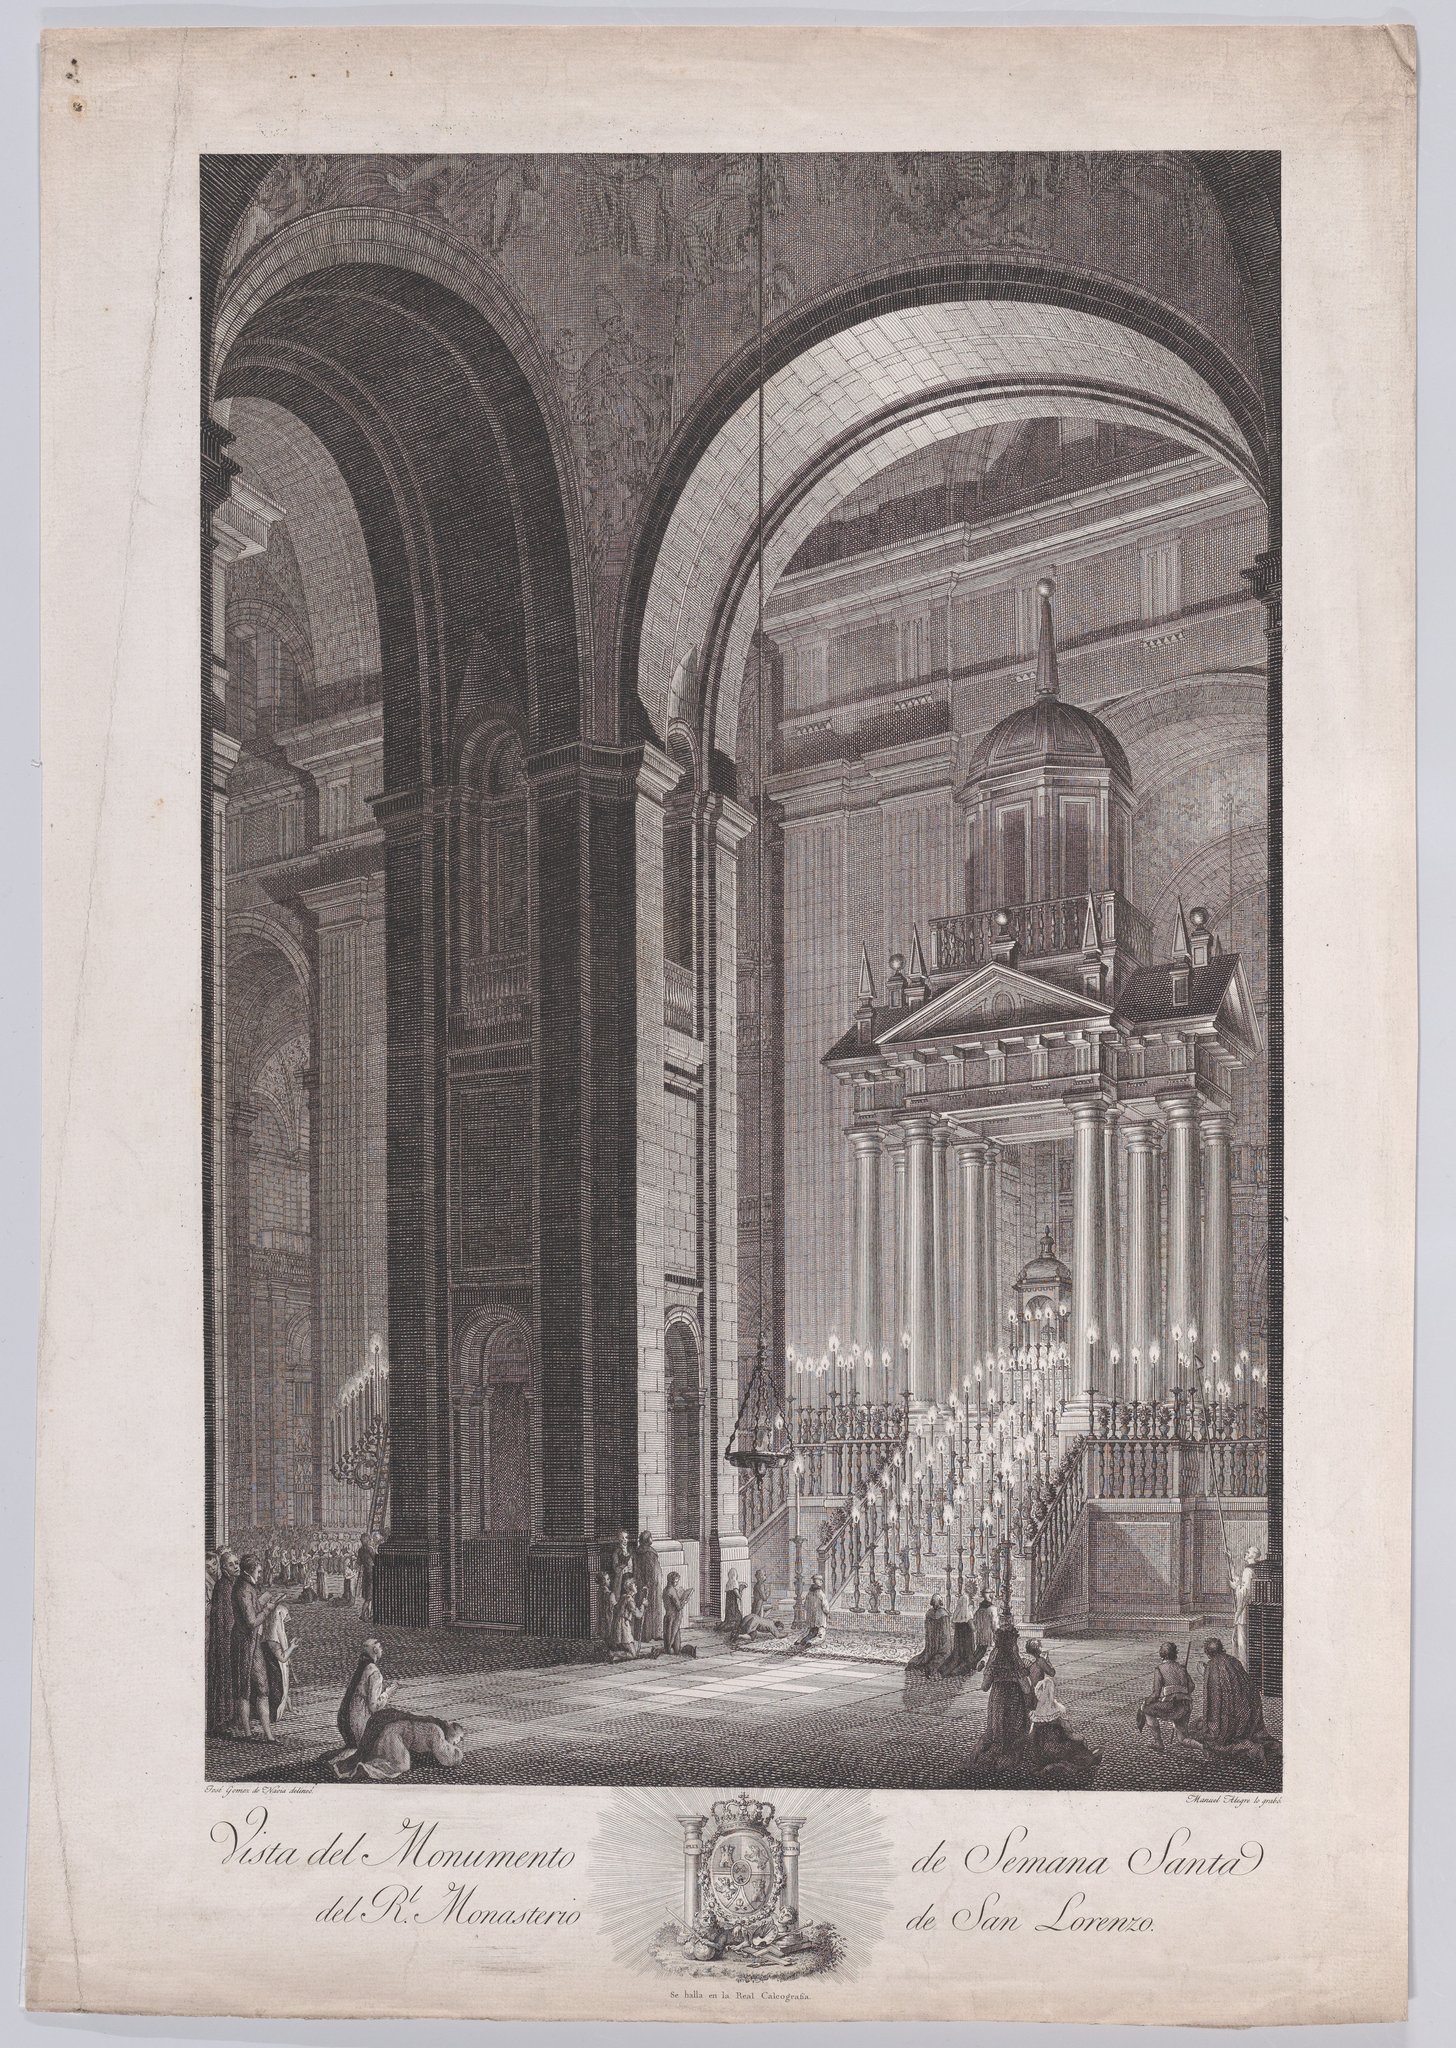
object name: print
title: The monument raised for Holy Week (Semana Santa) in the Church of the monastery of El Escorial, from "Views of El Escorial"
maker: manuel alegre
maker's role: artist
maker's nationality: spanish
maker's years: 1768-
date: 1790-1800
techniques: engraving, etching